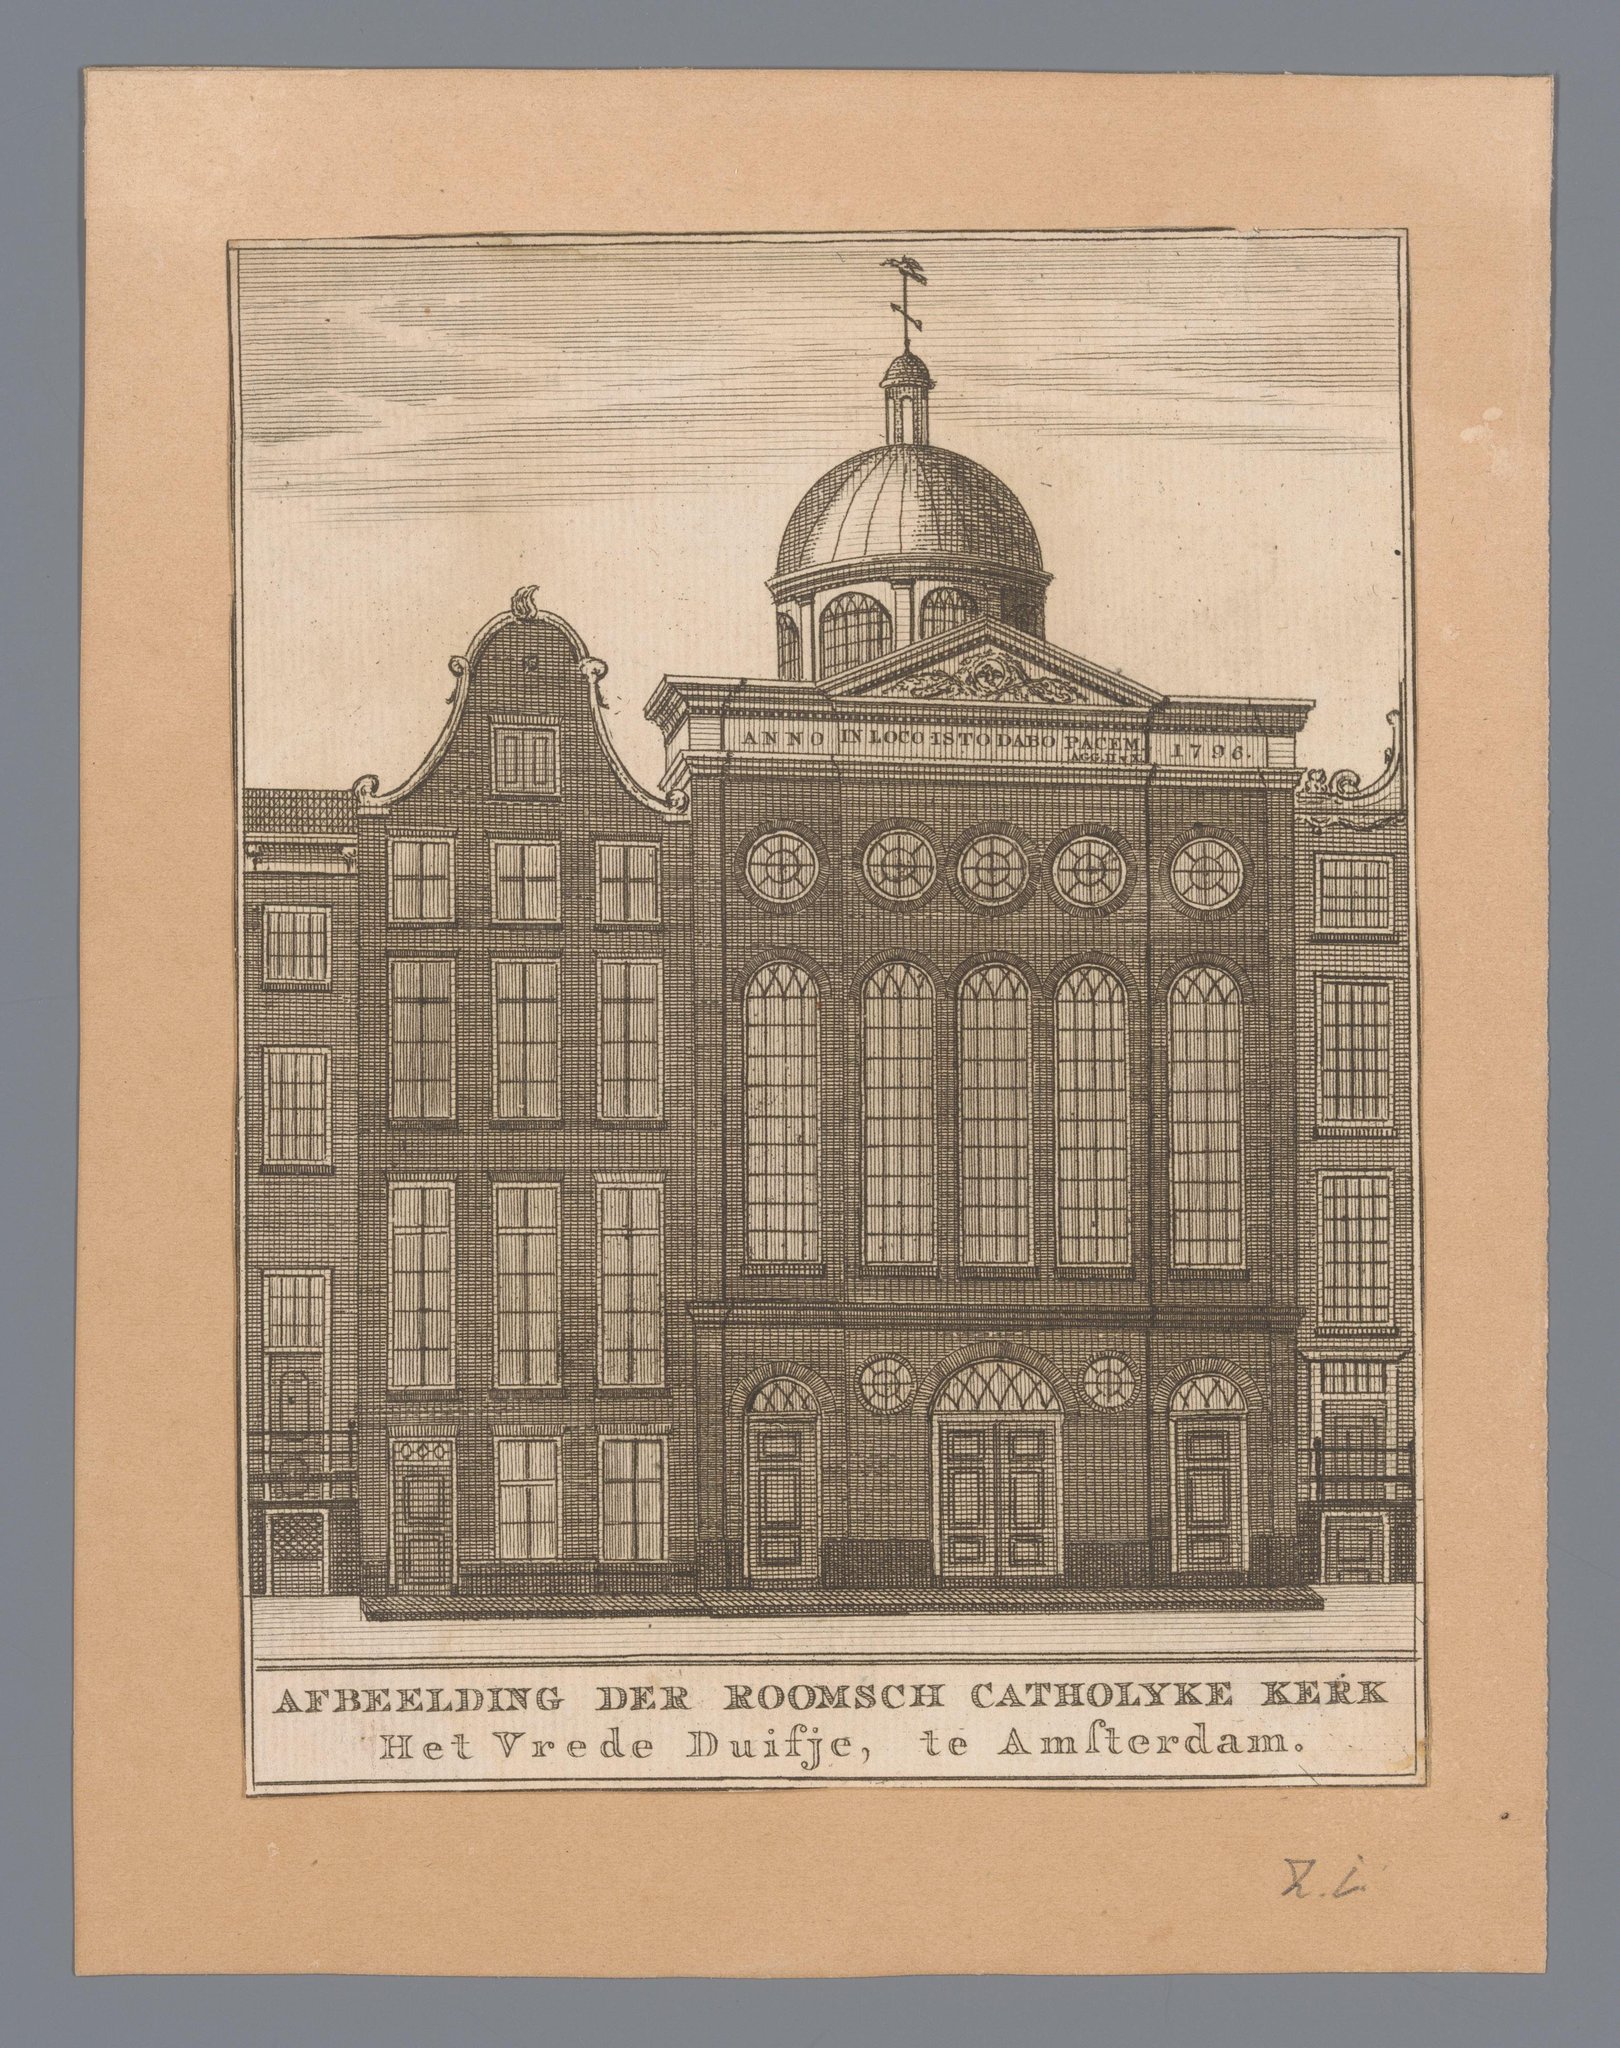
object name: print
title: Gezicht op de Rooms Katholieke kerk Het Vrede-Duifje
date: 1708-1796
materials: paper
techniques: etching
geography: amsterdam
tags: roman catholic church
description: De Rooms Katholieke schuilkerk Het Vrede-Duifje is in 1796 vervangen door De Duif aan de Prinsengracht.